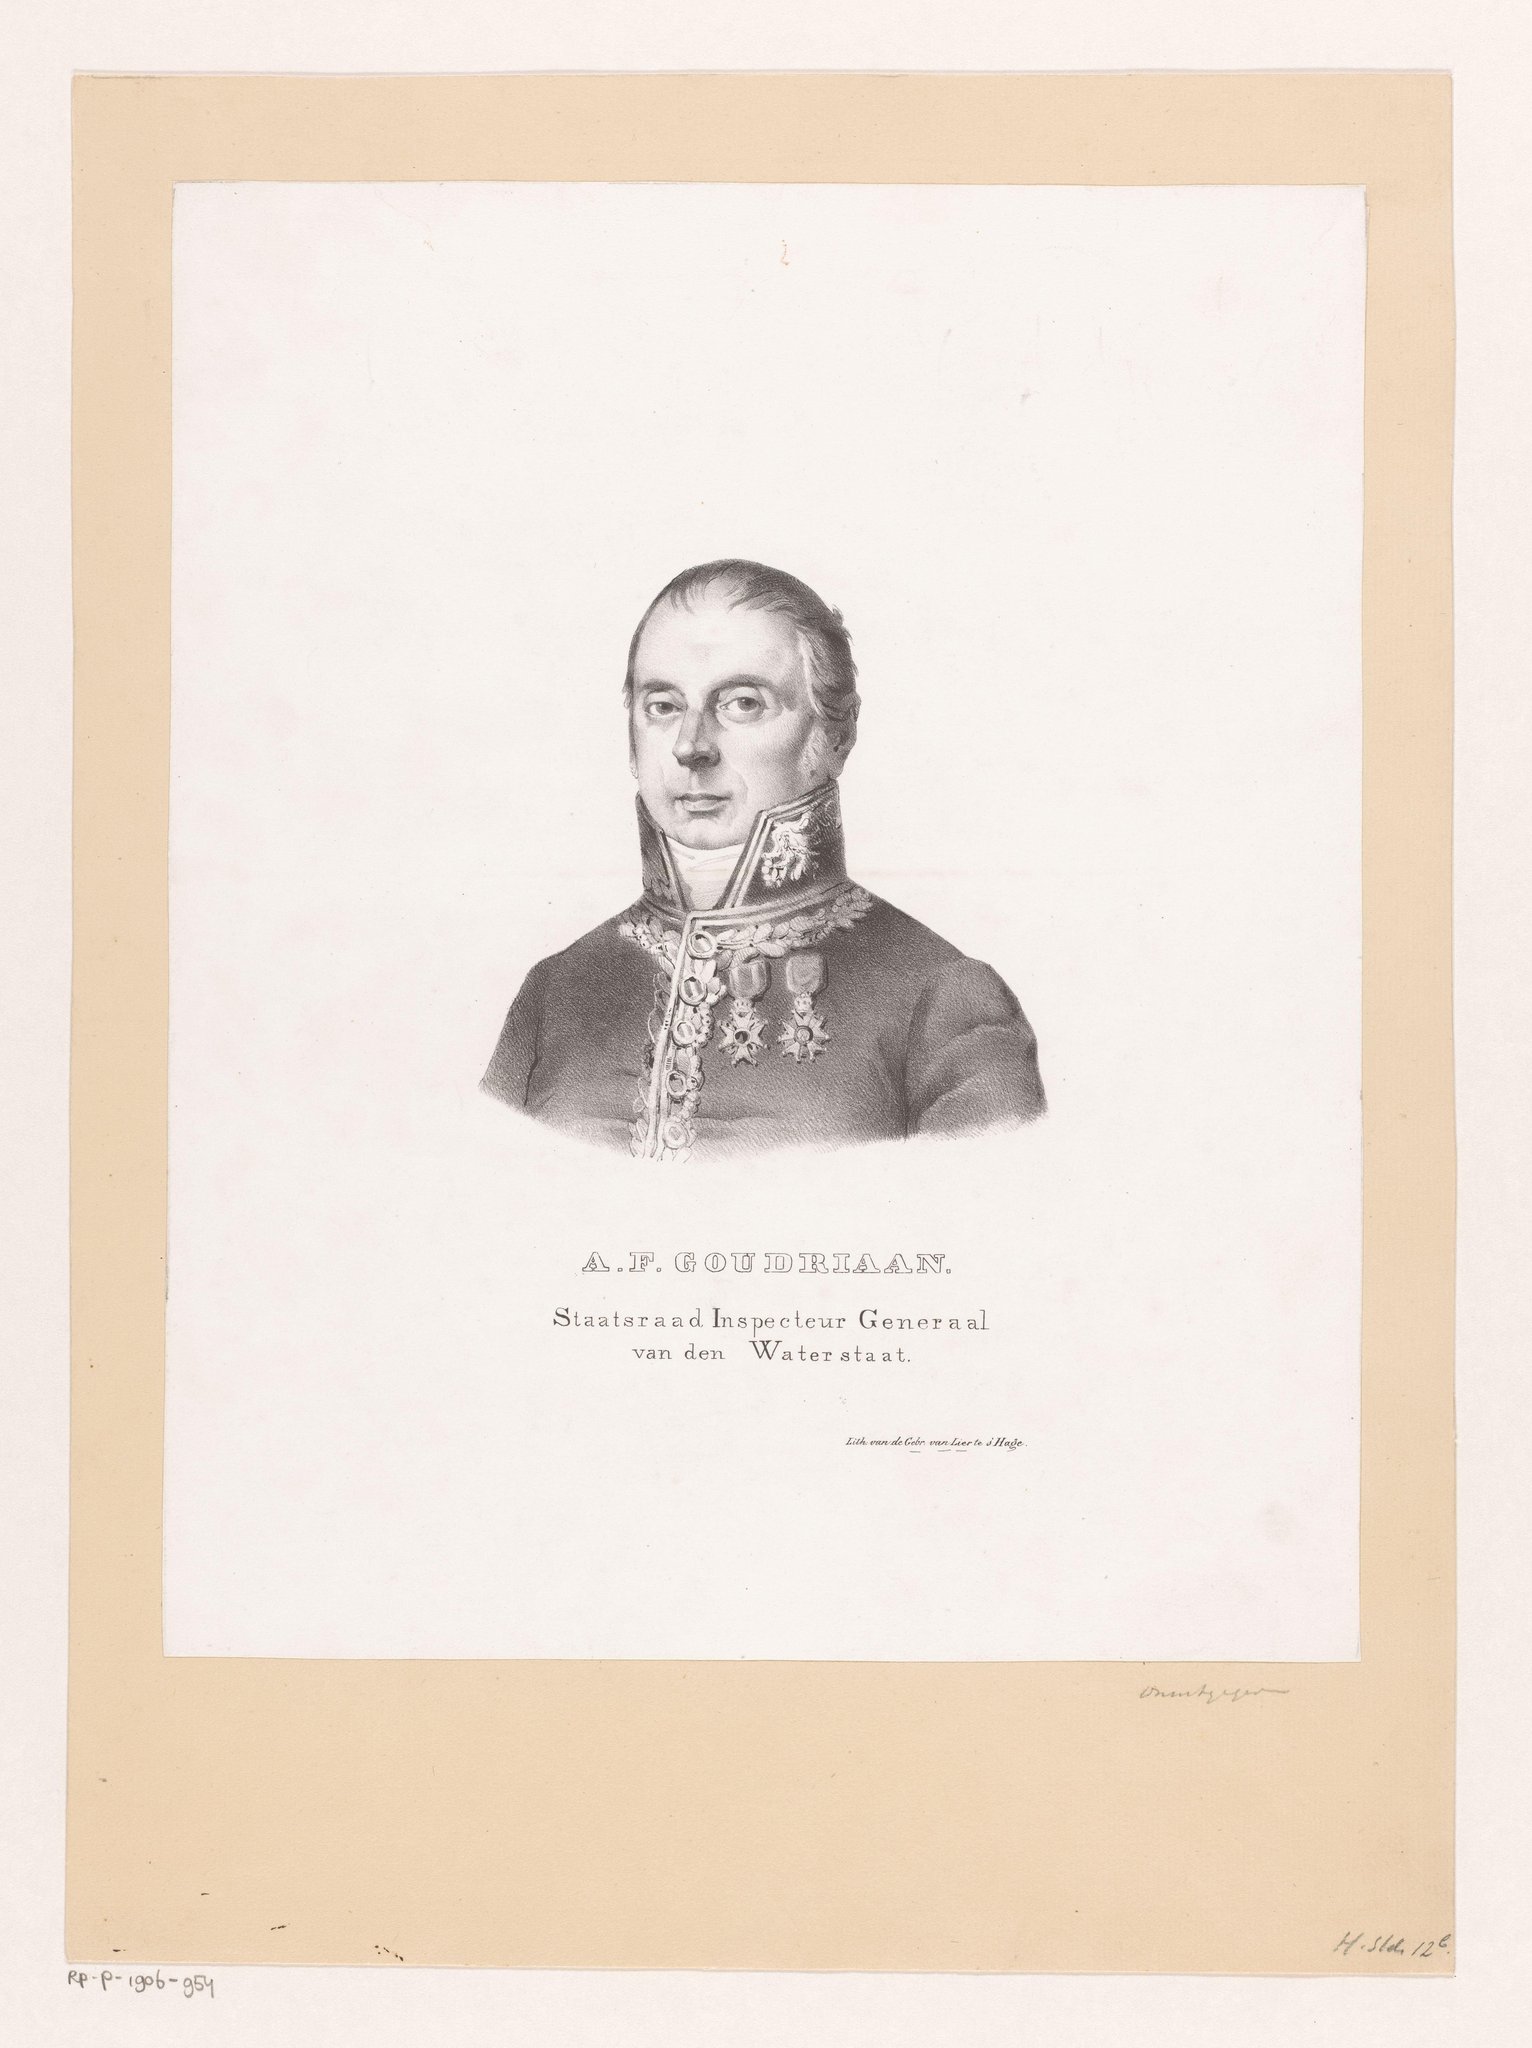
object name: print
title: Portret van Adrianus François Goudriaan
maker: Anonymous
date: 1834-1850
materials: paper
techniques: lithograph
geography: the hague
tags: knighthood order, historical persons (+ (full) bust portrait)